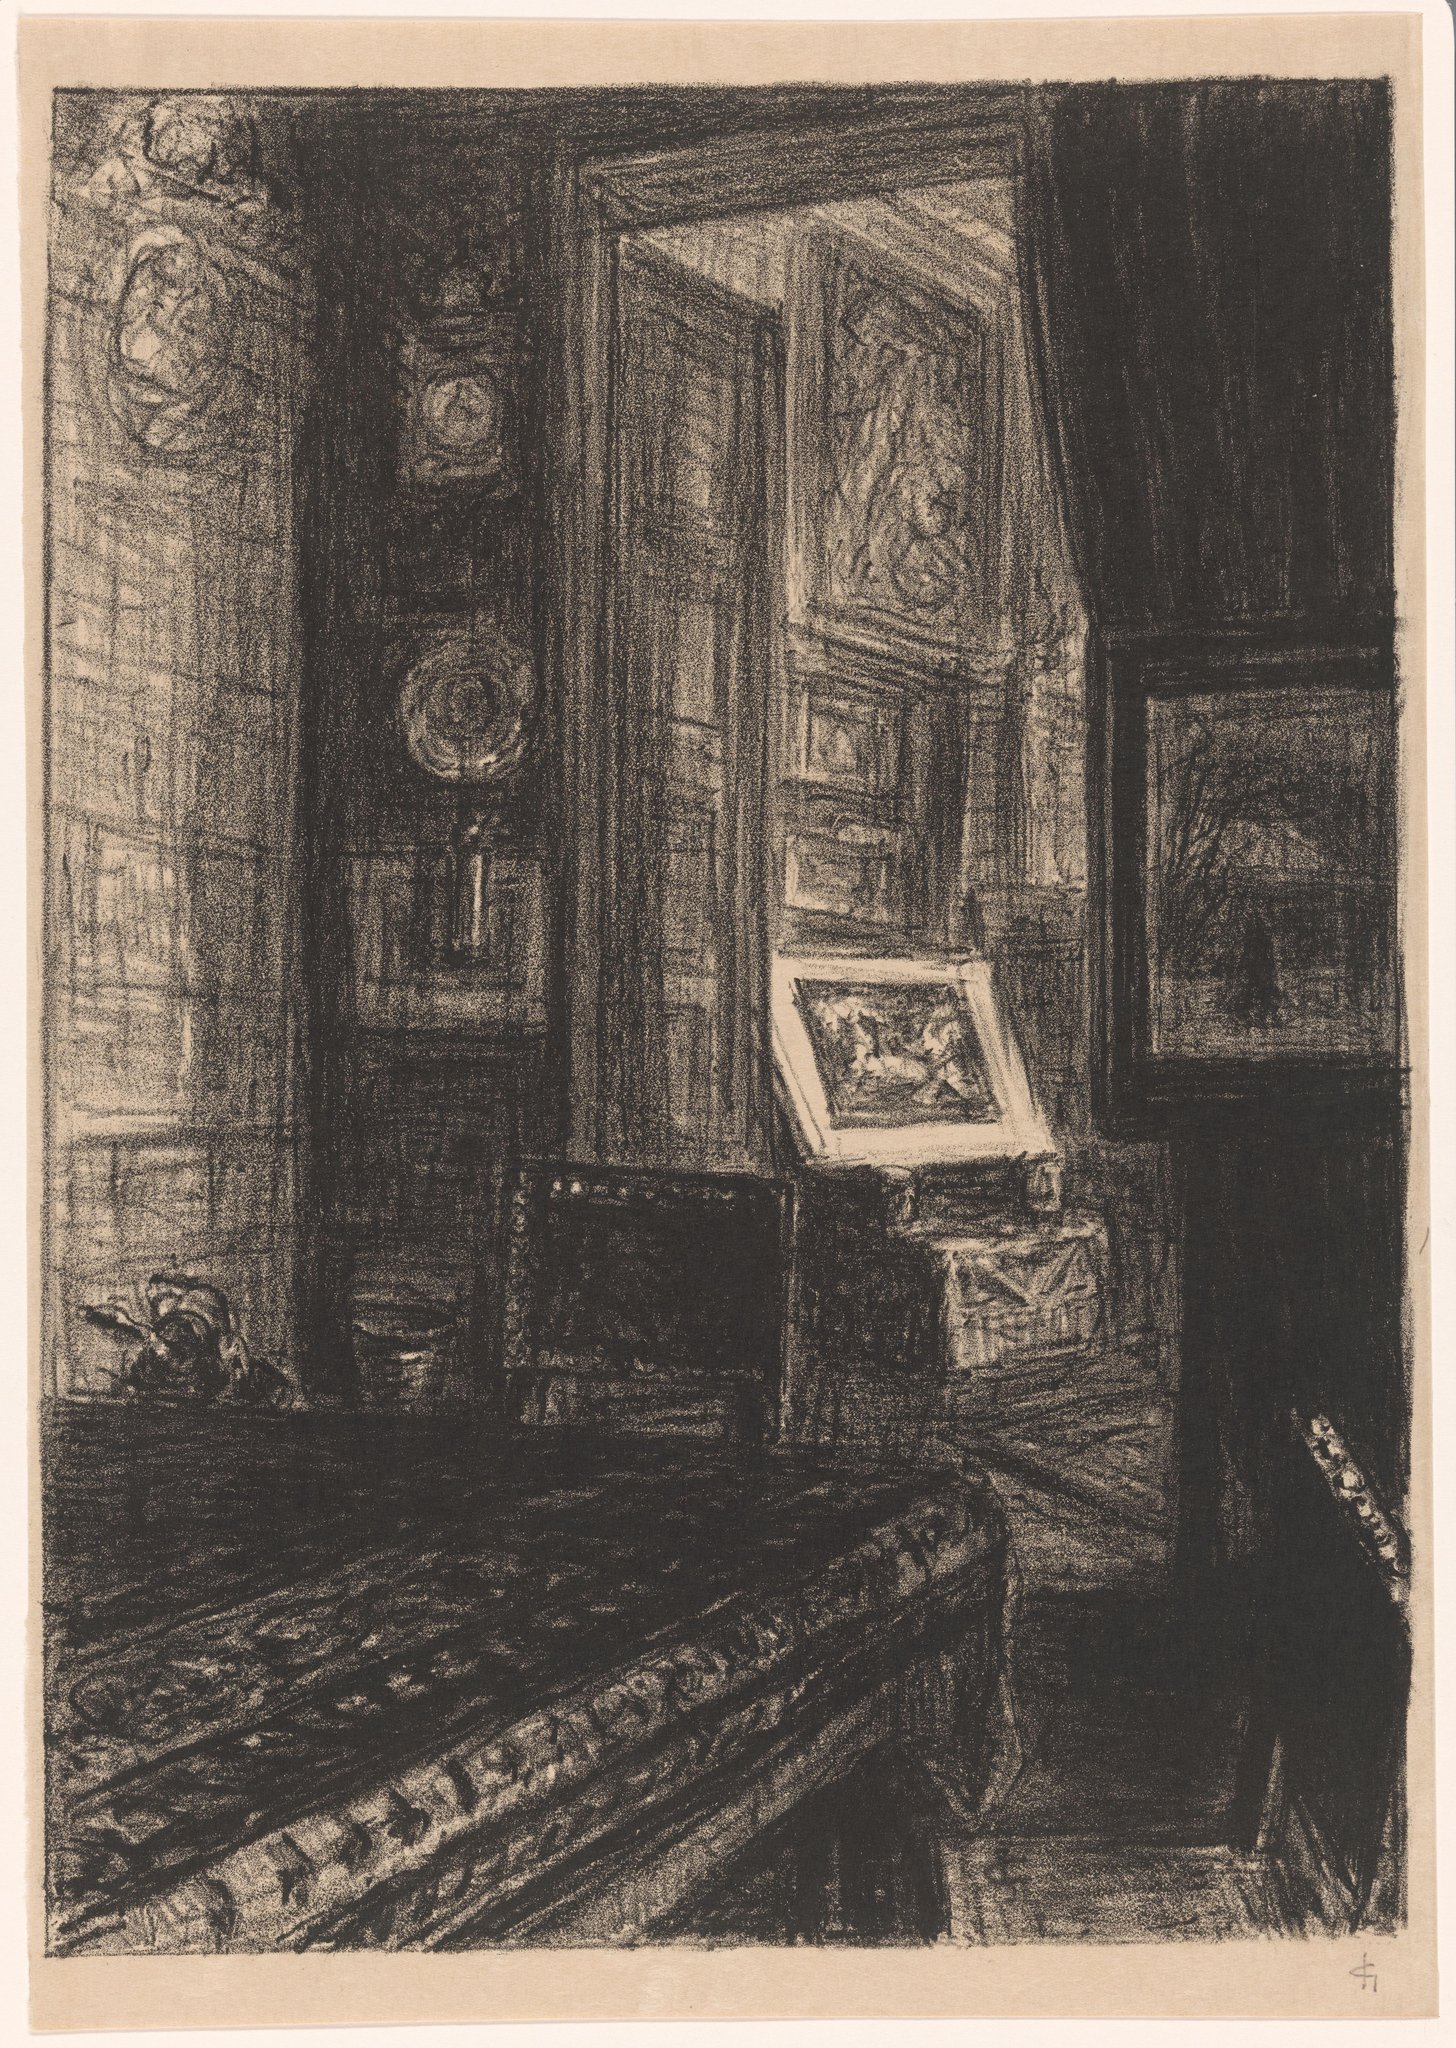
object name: print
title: Interieur van een huiskamer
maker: carel nicolaas storm van s-gravesande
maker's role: draughtsman, print maker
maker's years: 1841-1924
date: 1851-1902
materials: paper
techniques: lithograph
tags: communal rooms, picture, painting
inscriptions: collector's mark: Lugt 2228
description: Mogelijk vermeld in: Storm van 's-Gravesande, Charles. Catalogue des eaux-fortes et lithographies. New York: s.n., 1903, of in een onbekende latere uitgave van het manuscript. Vermoedelijk vermeld als catalogusnummer 52.